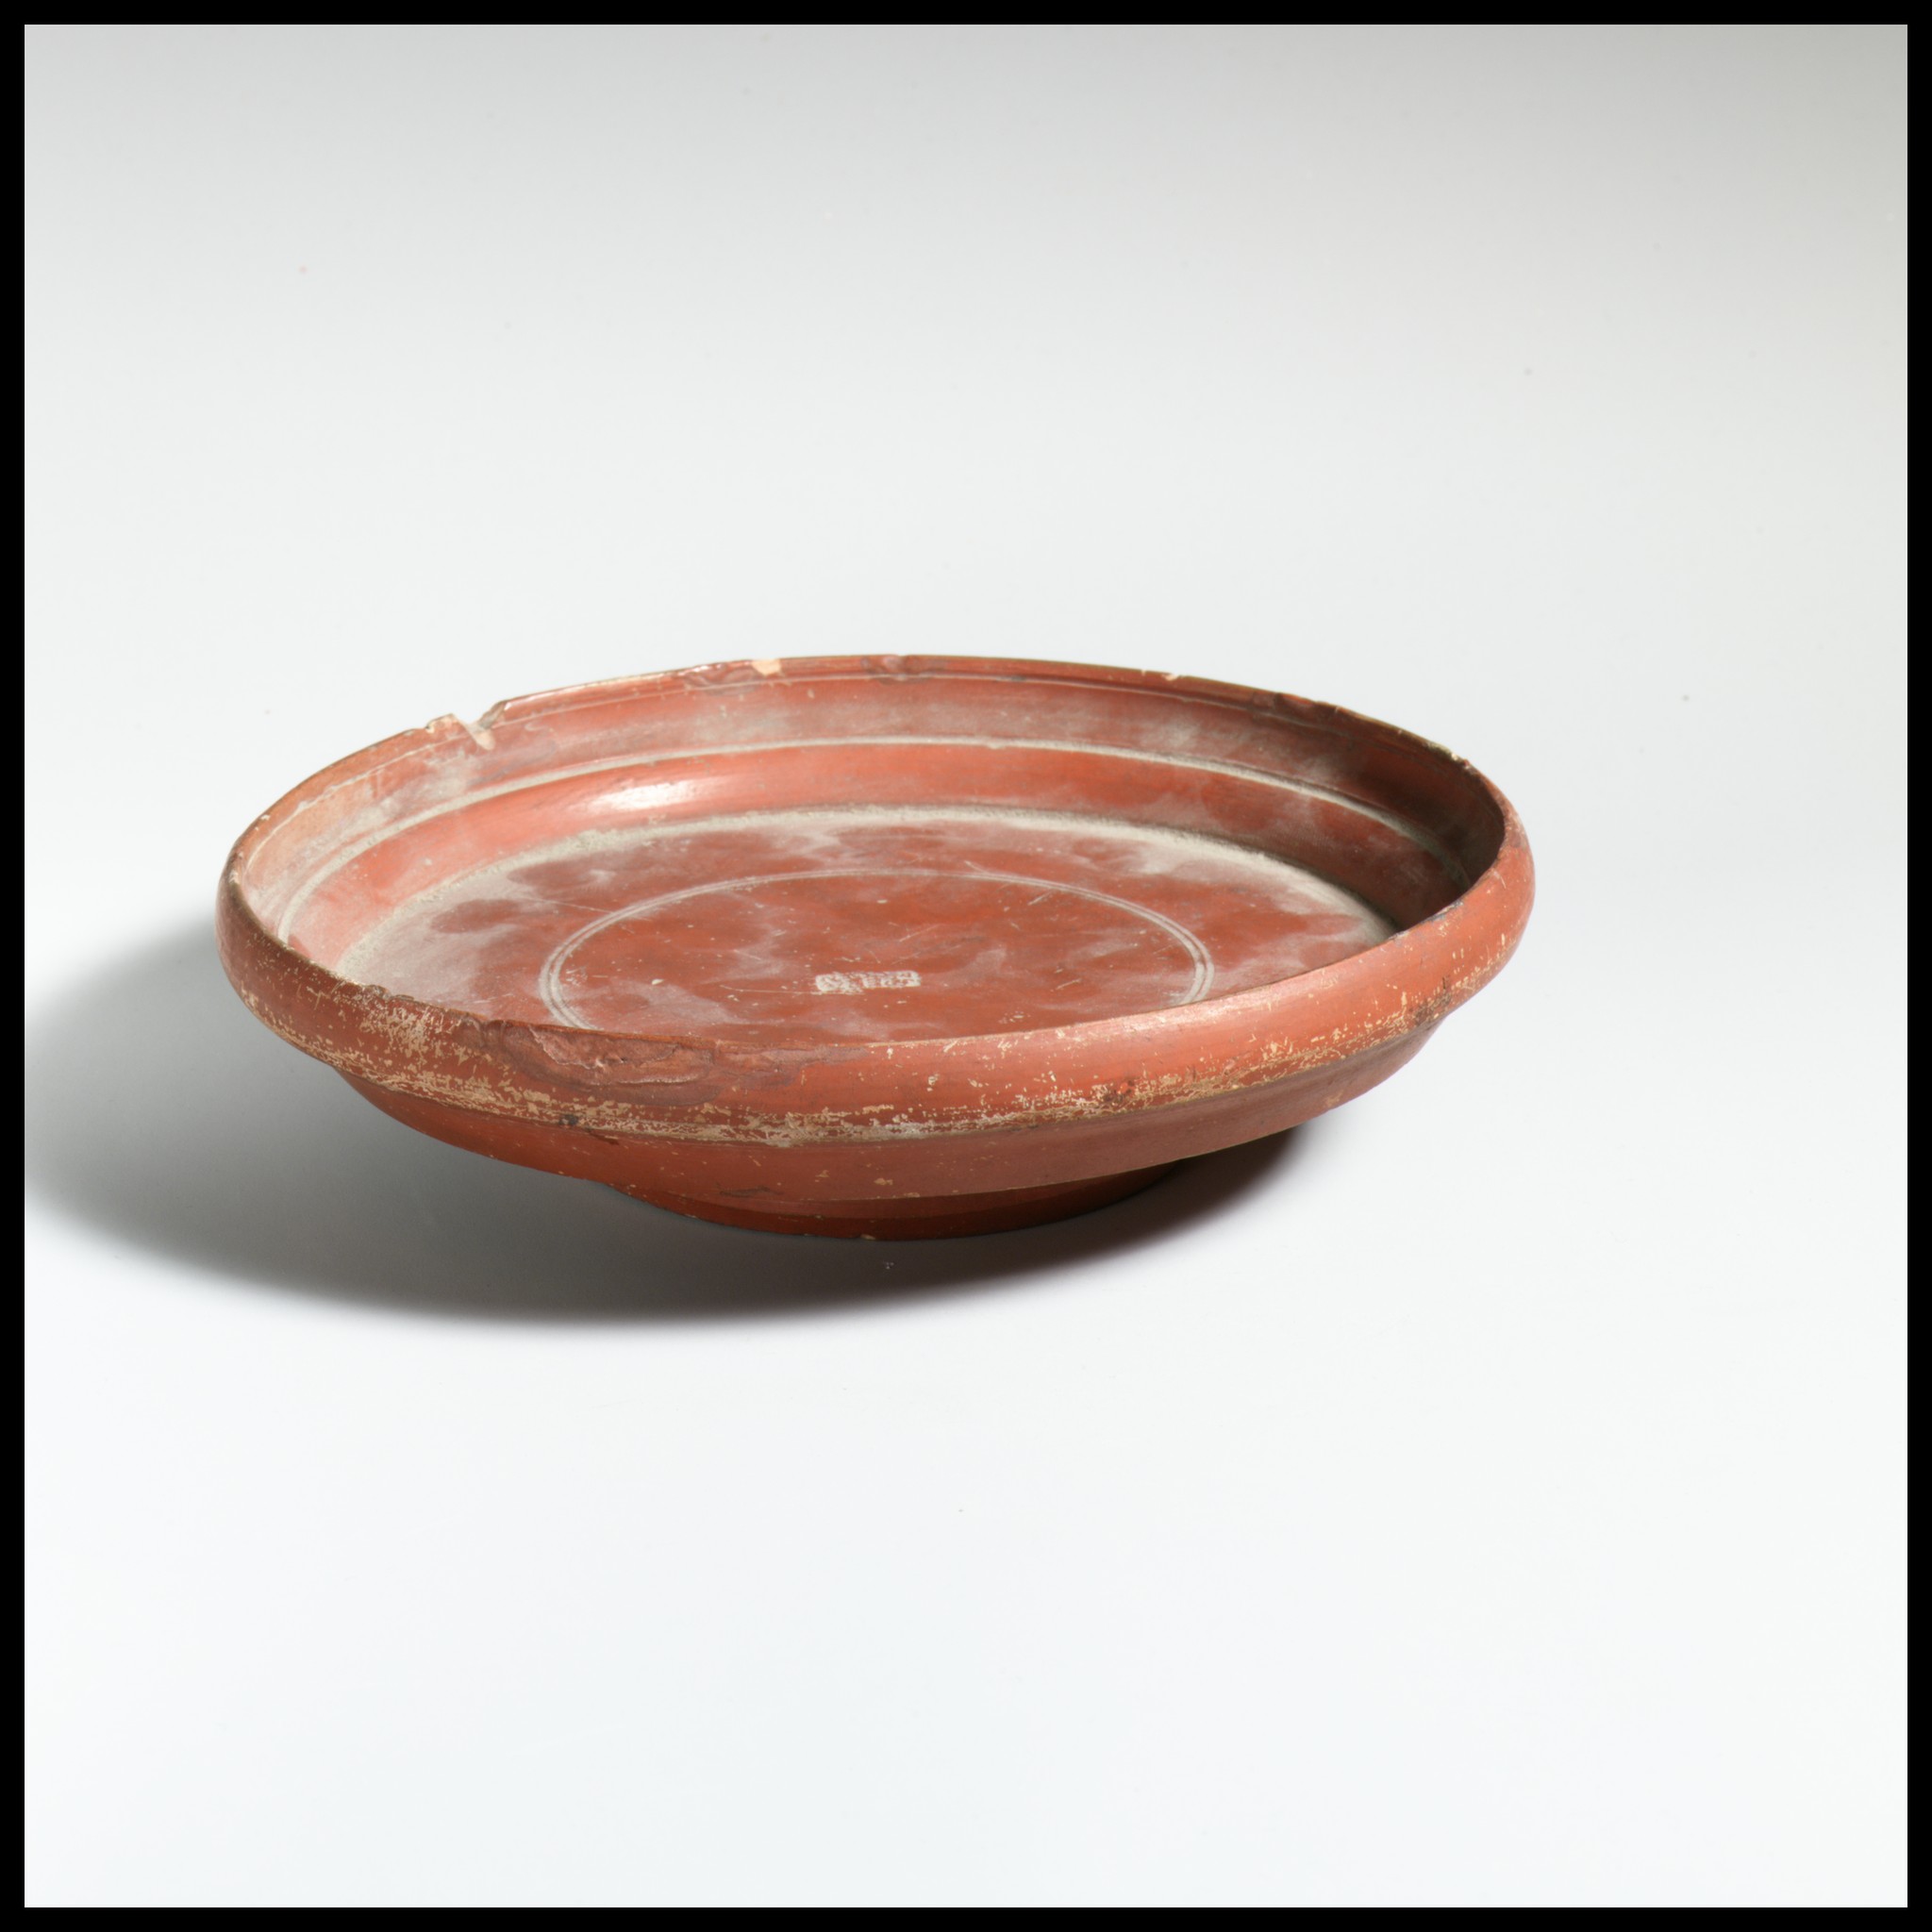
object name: plate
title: Terracotta plate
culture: roman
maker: speratus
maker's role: artist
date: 1-33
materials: terracotta